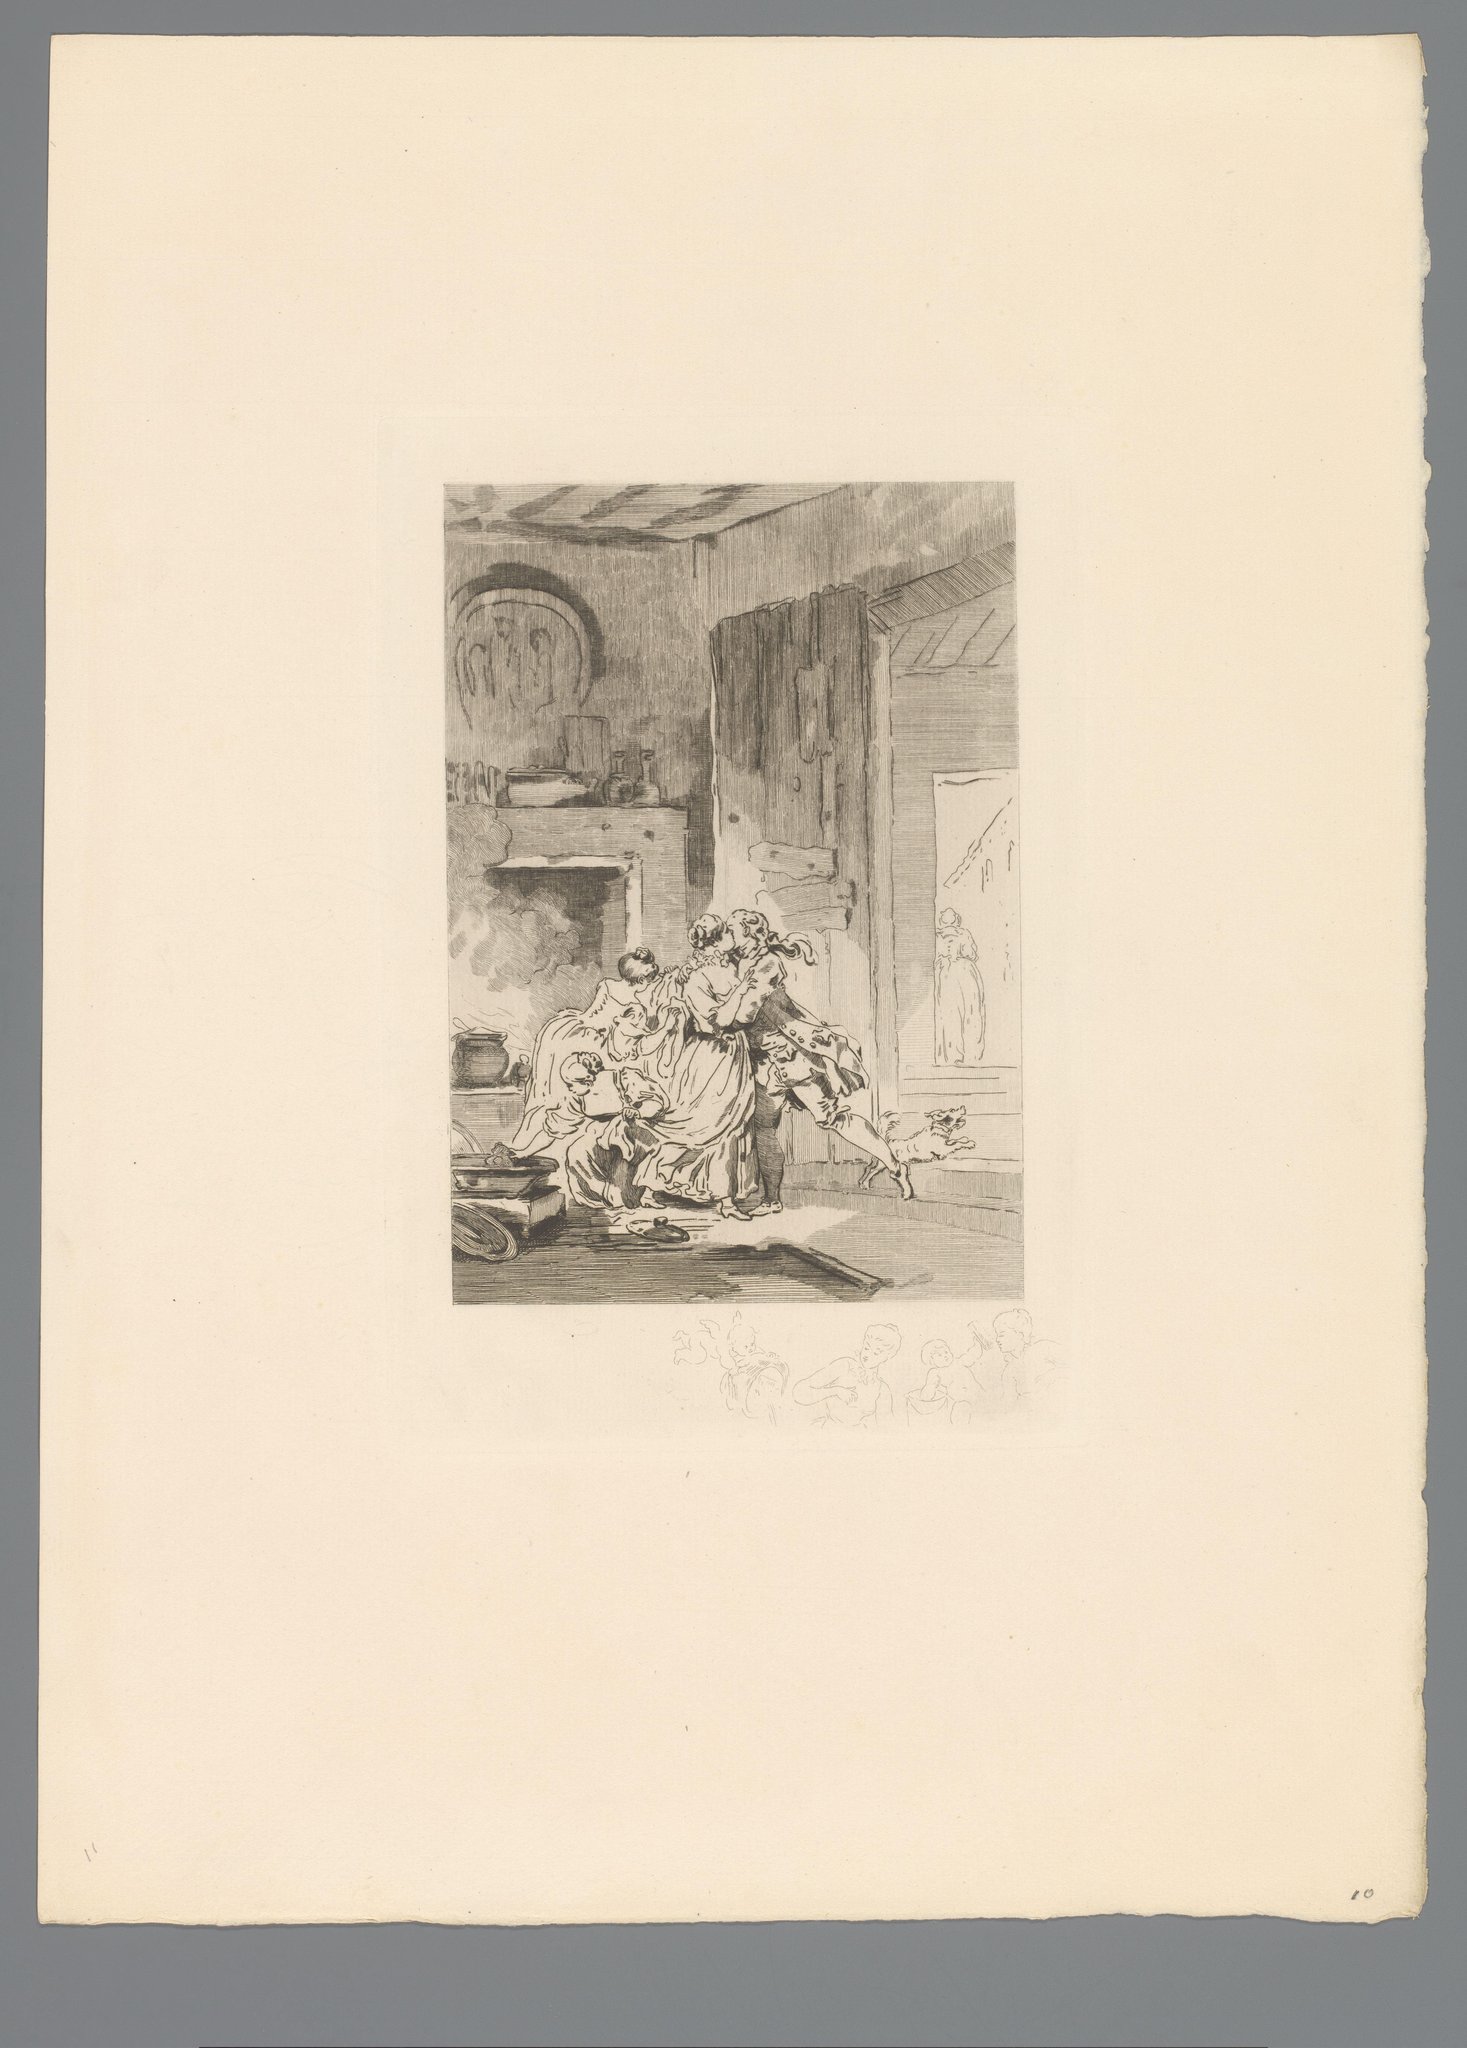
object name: photomechanical print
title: Figures des Contes de La Fontaine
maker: Anonymous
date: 1880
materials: paper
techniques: photoaquatint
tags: care and laundering of clothes; home sewing, lovers' meeting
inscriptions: collector's mark:, collector's mark: Lugt 2228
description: Martial Potémont maakte etsen naar de tekeningen van Fragonard, die zich bevonden in een manuscript in de collectie van de verzamelaar Eugène Paillet. Rouquette bood hem aan de tekeningen zo exact mogelijk in prent te laten brengen door Martial Potémont: dit resulteerde in een serie van 57 etsen. Vervolgens werden deze gereproduceerd door middel van heliogravure. Deze omslag betreft een editie voor de letter, "Eau forte pure", de 1e staat van 3 waar men uit kon kiezen bij deze serie.